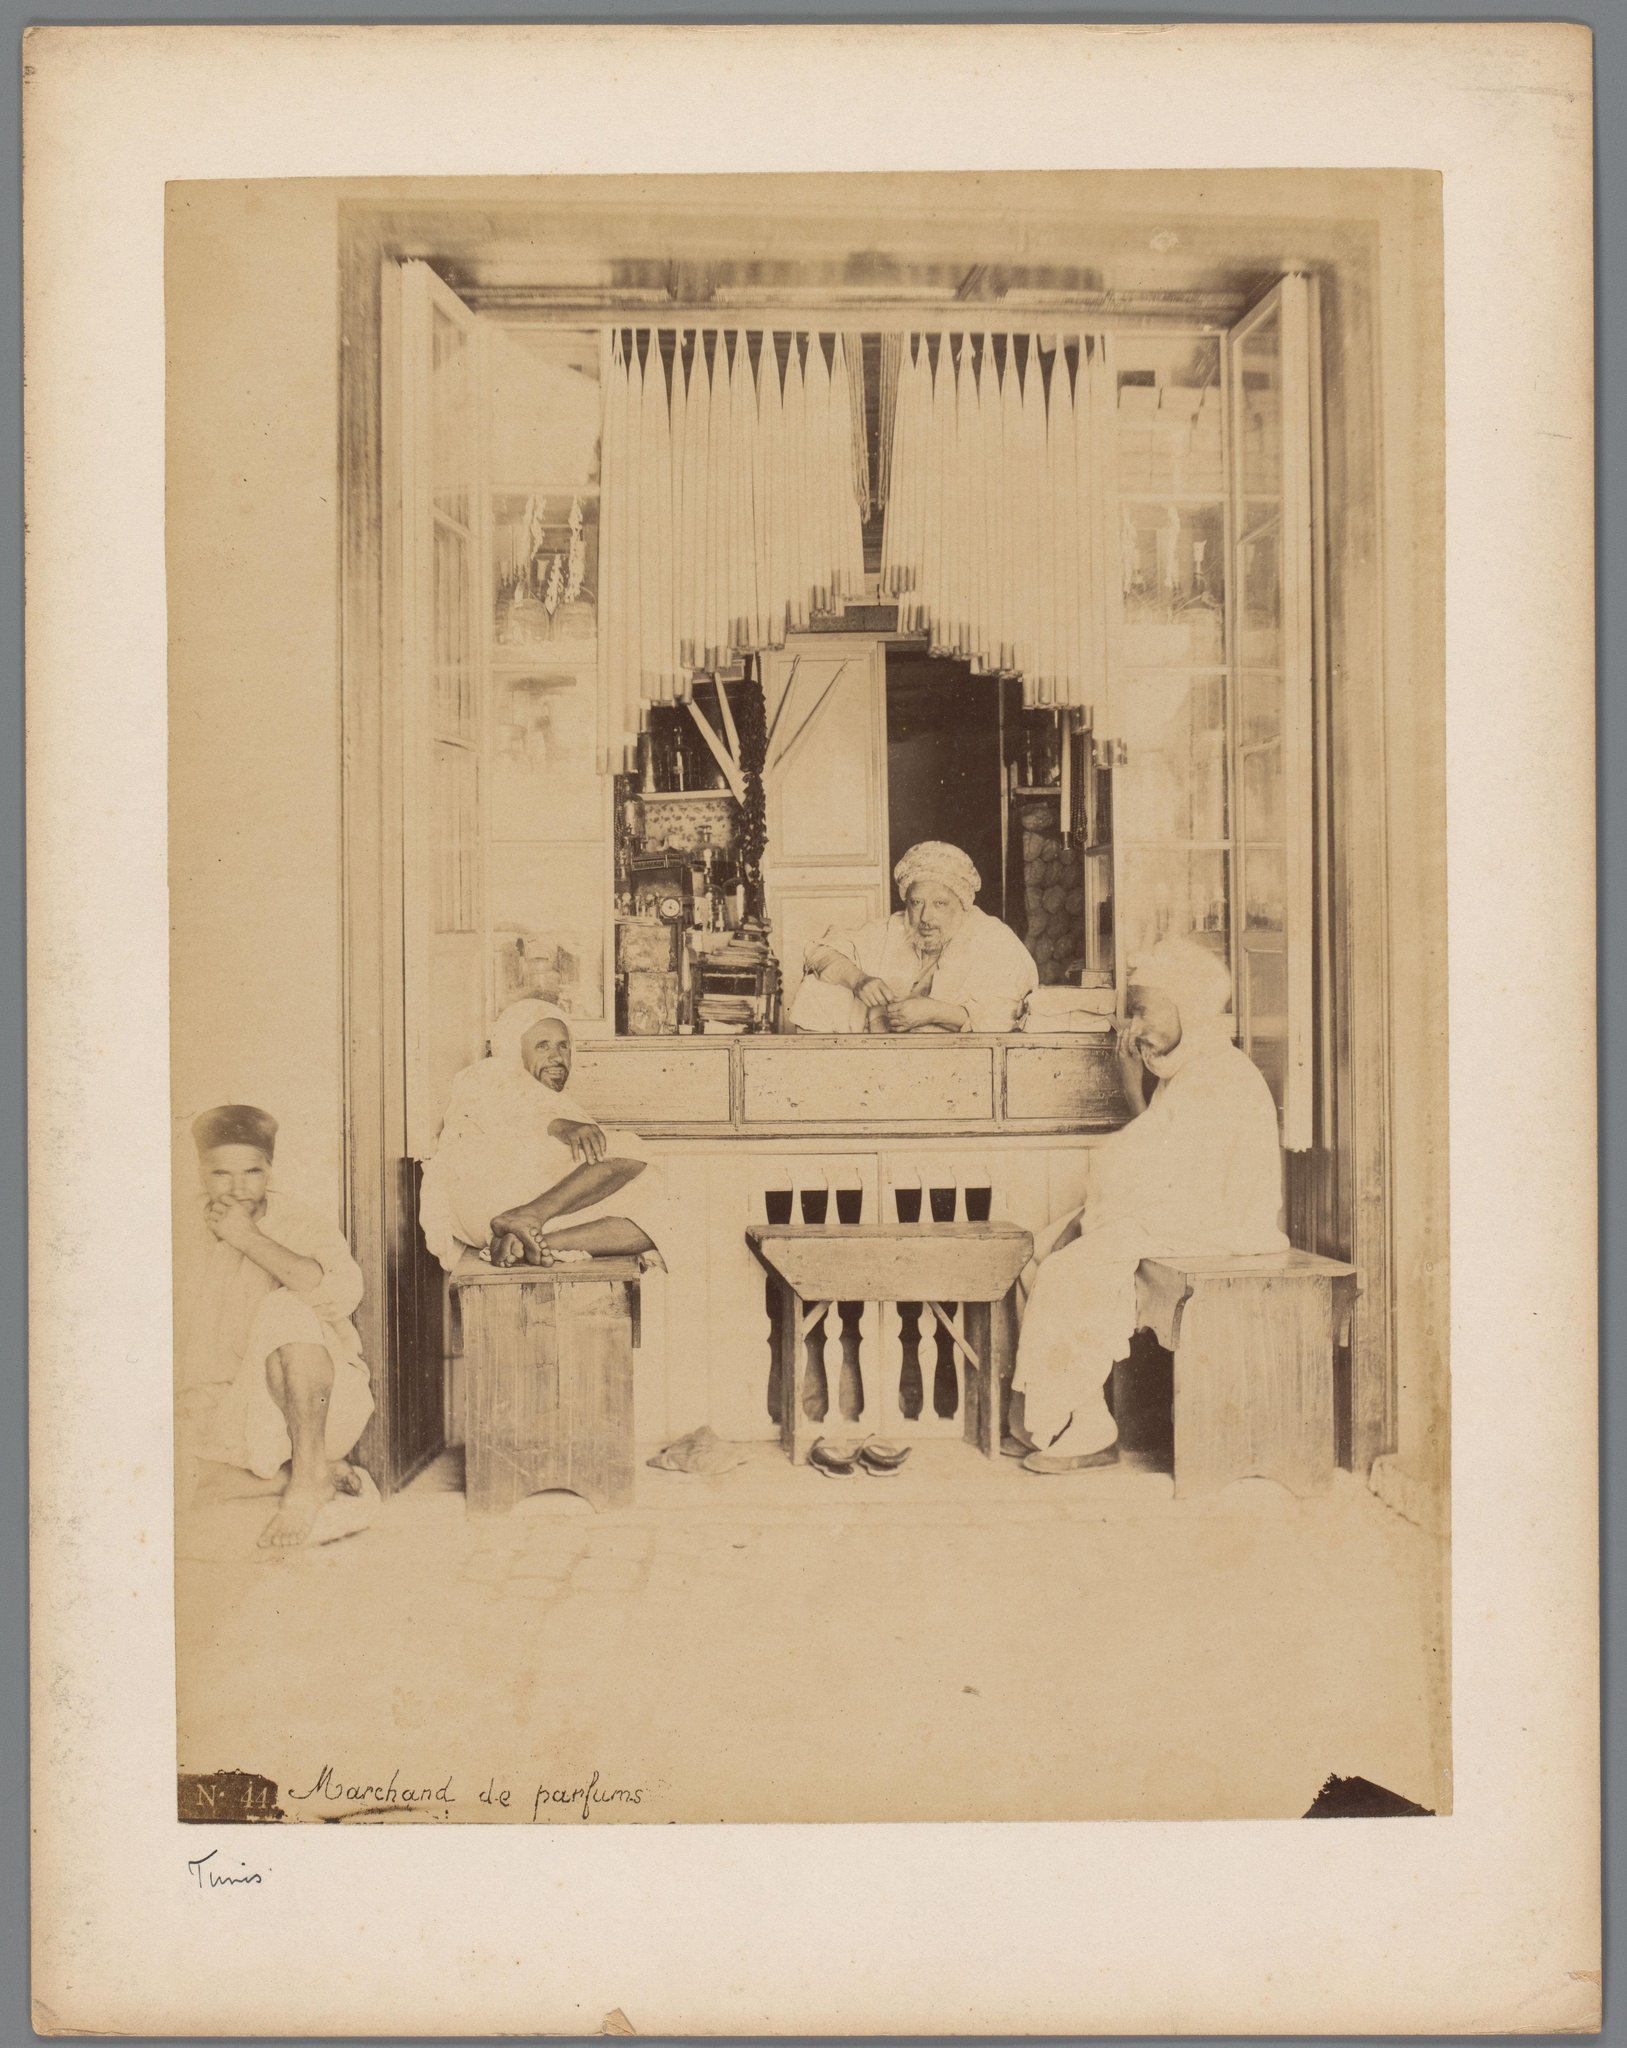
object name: photograph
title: Marchand de parfums, Tunis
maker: Anonymous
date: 1860-1900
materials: cardboard, paper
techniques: albumen print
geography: tunis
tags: shop, store, using scents, perfumes, ointments, etc.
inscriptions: number: ‘N. 44.’